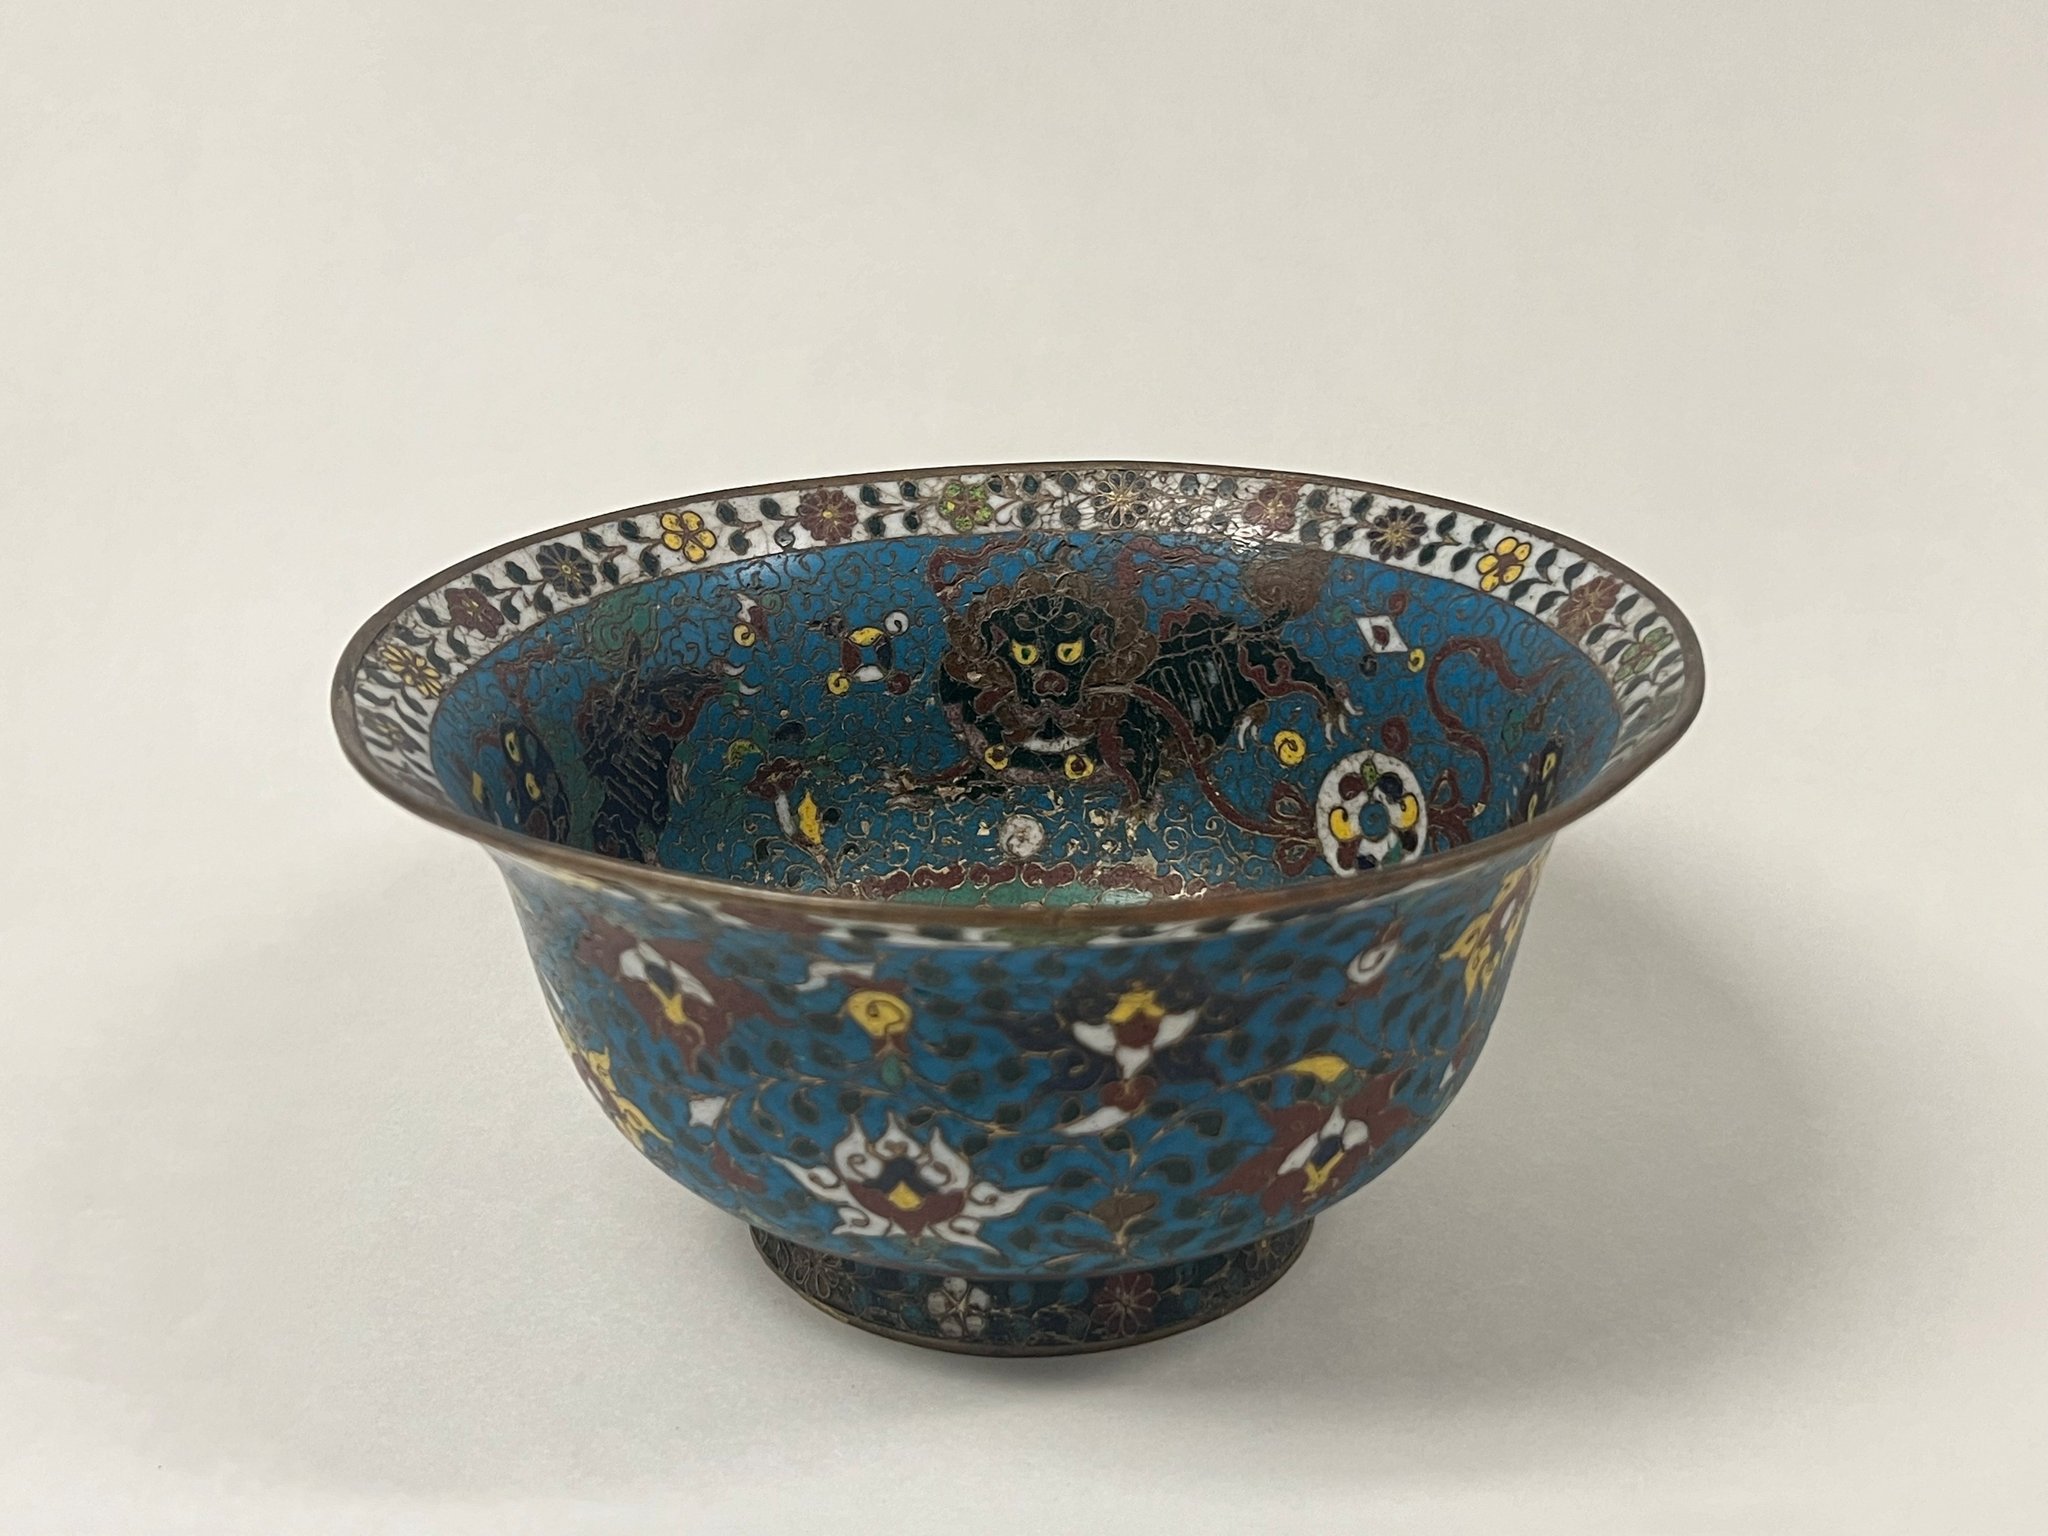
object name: bowl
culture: chinese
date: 1368-1644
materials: enamel, copper gilt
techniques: enamel